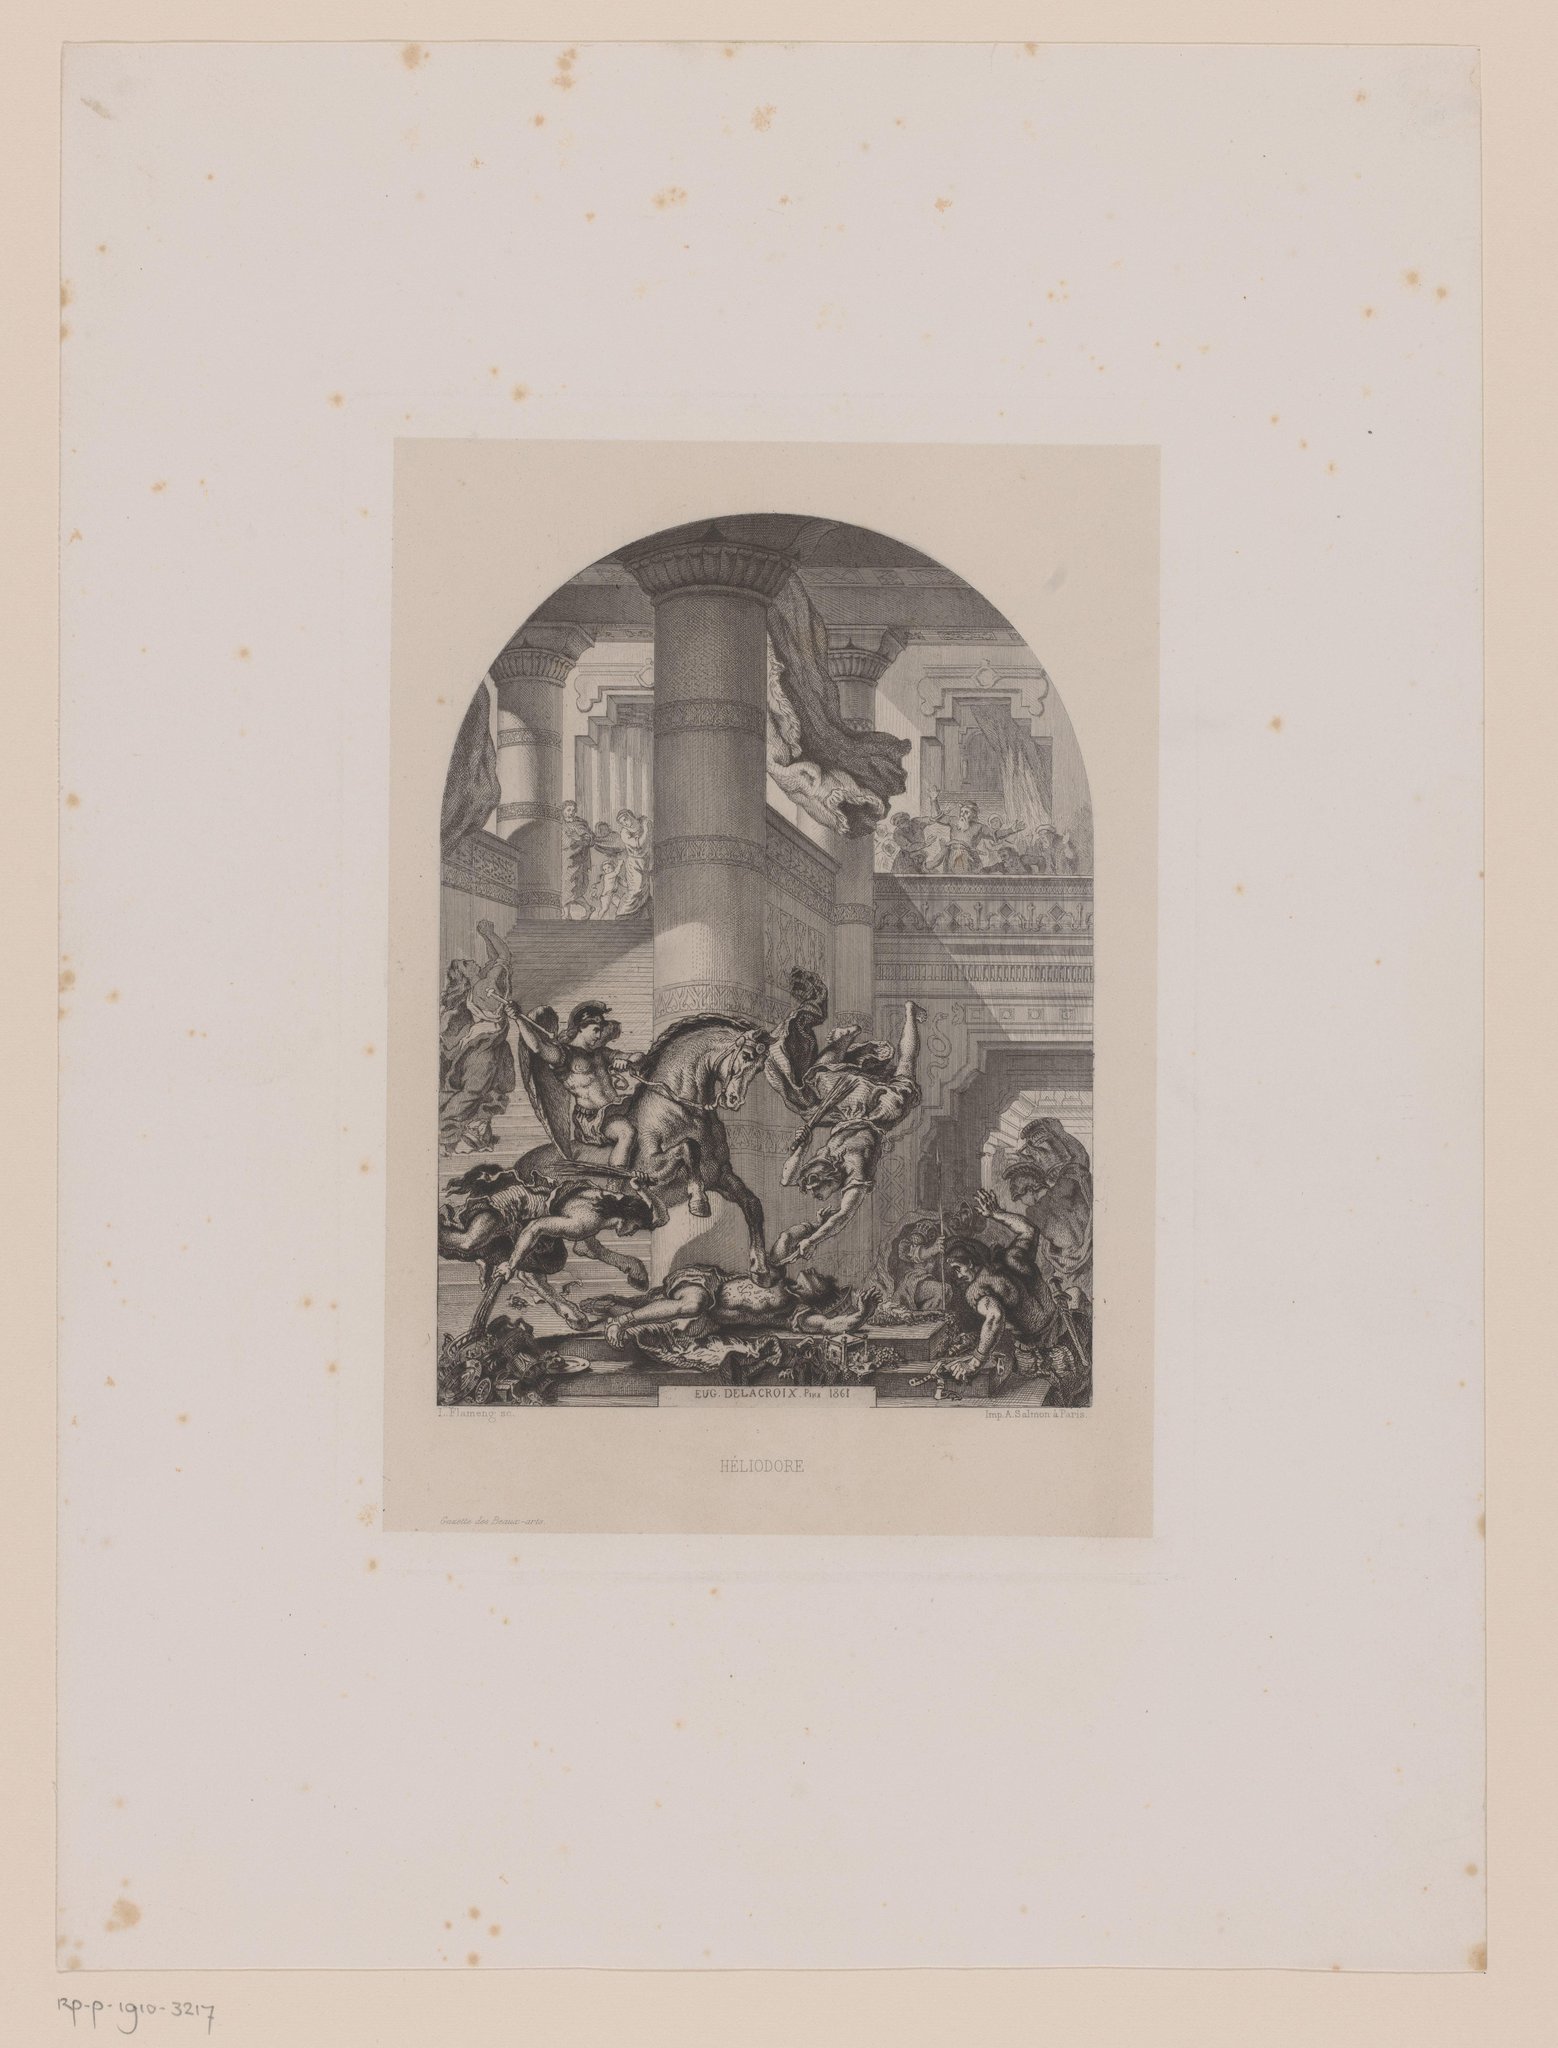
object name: print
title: Verdrijving van Heliodorus uit de tempel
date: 1861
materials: paper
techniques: etching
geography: paris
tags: heliodorus in the temple, attacked by a man (or angel) on horseback and two other men (or angels) (2 maccabees 3:7-35)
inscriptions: collector's mark: Lugt 2228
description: Prent uit: Gazette des beaux-arts (1862), dl. 3, p. 512.